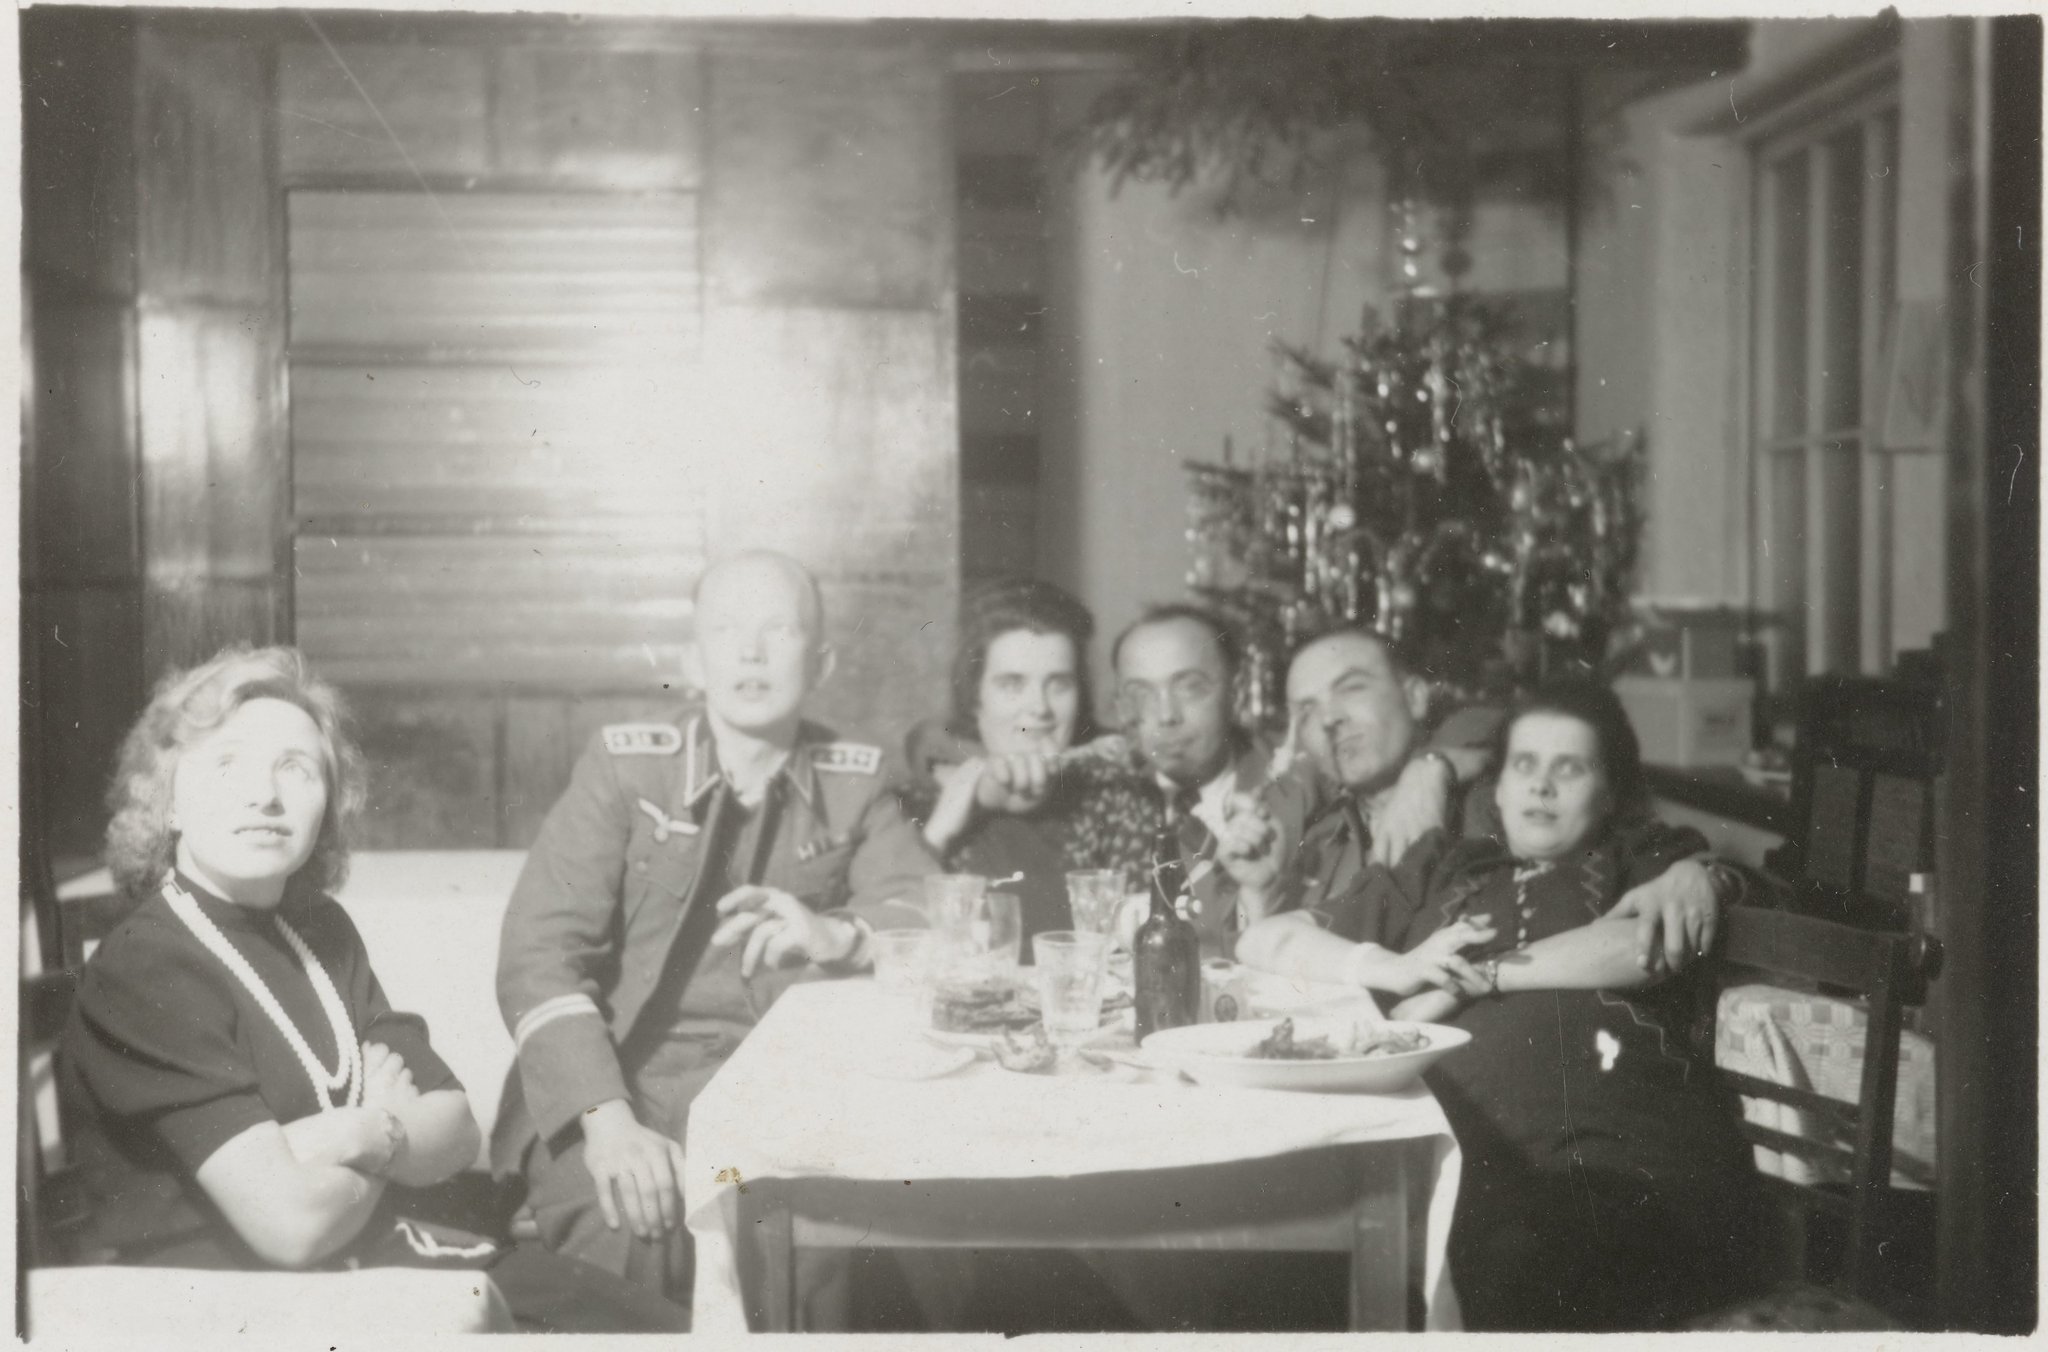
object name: photograph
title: Drie leden van de Wehrmacht en drie vrouwen rond een tafel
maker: Anonymous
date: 1940-1945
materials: photographic support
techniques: gelatin silver print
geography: netherlands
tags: netherlands, germany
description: Drie leden van de Wehrmacht en drie vrouwen rond een tafel. Op de achtergrond een kerstboom. Foto behorend bij album 'Kriegserinnerungen'.